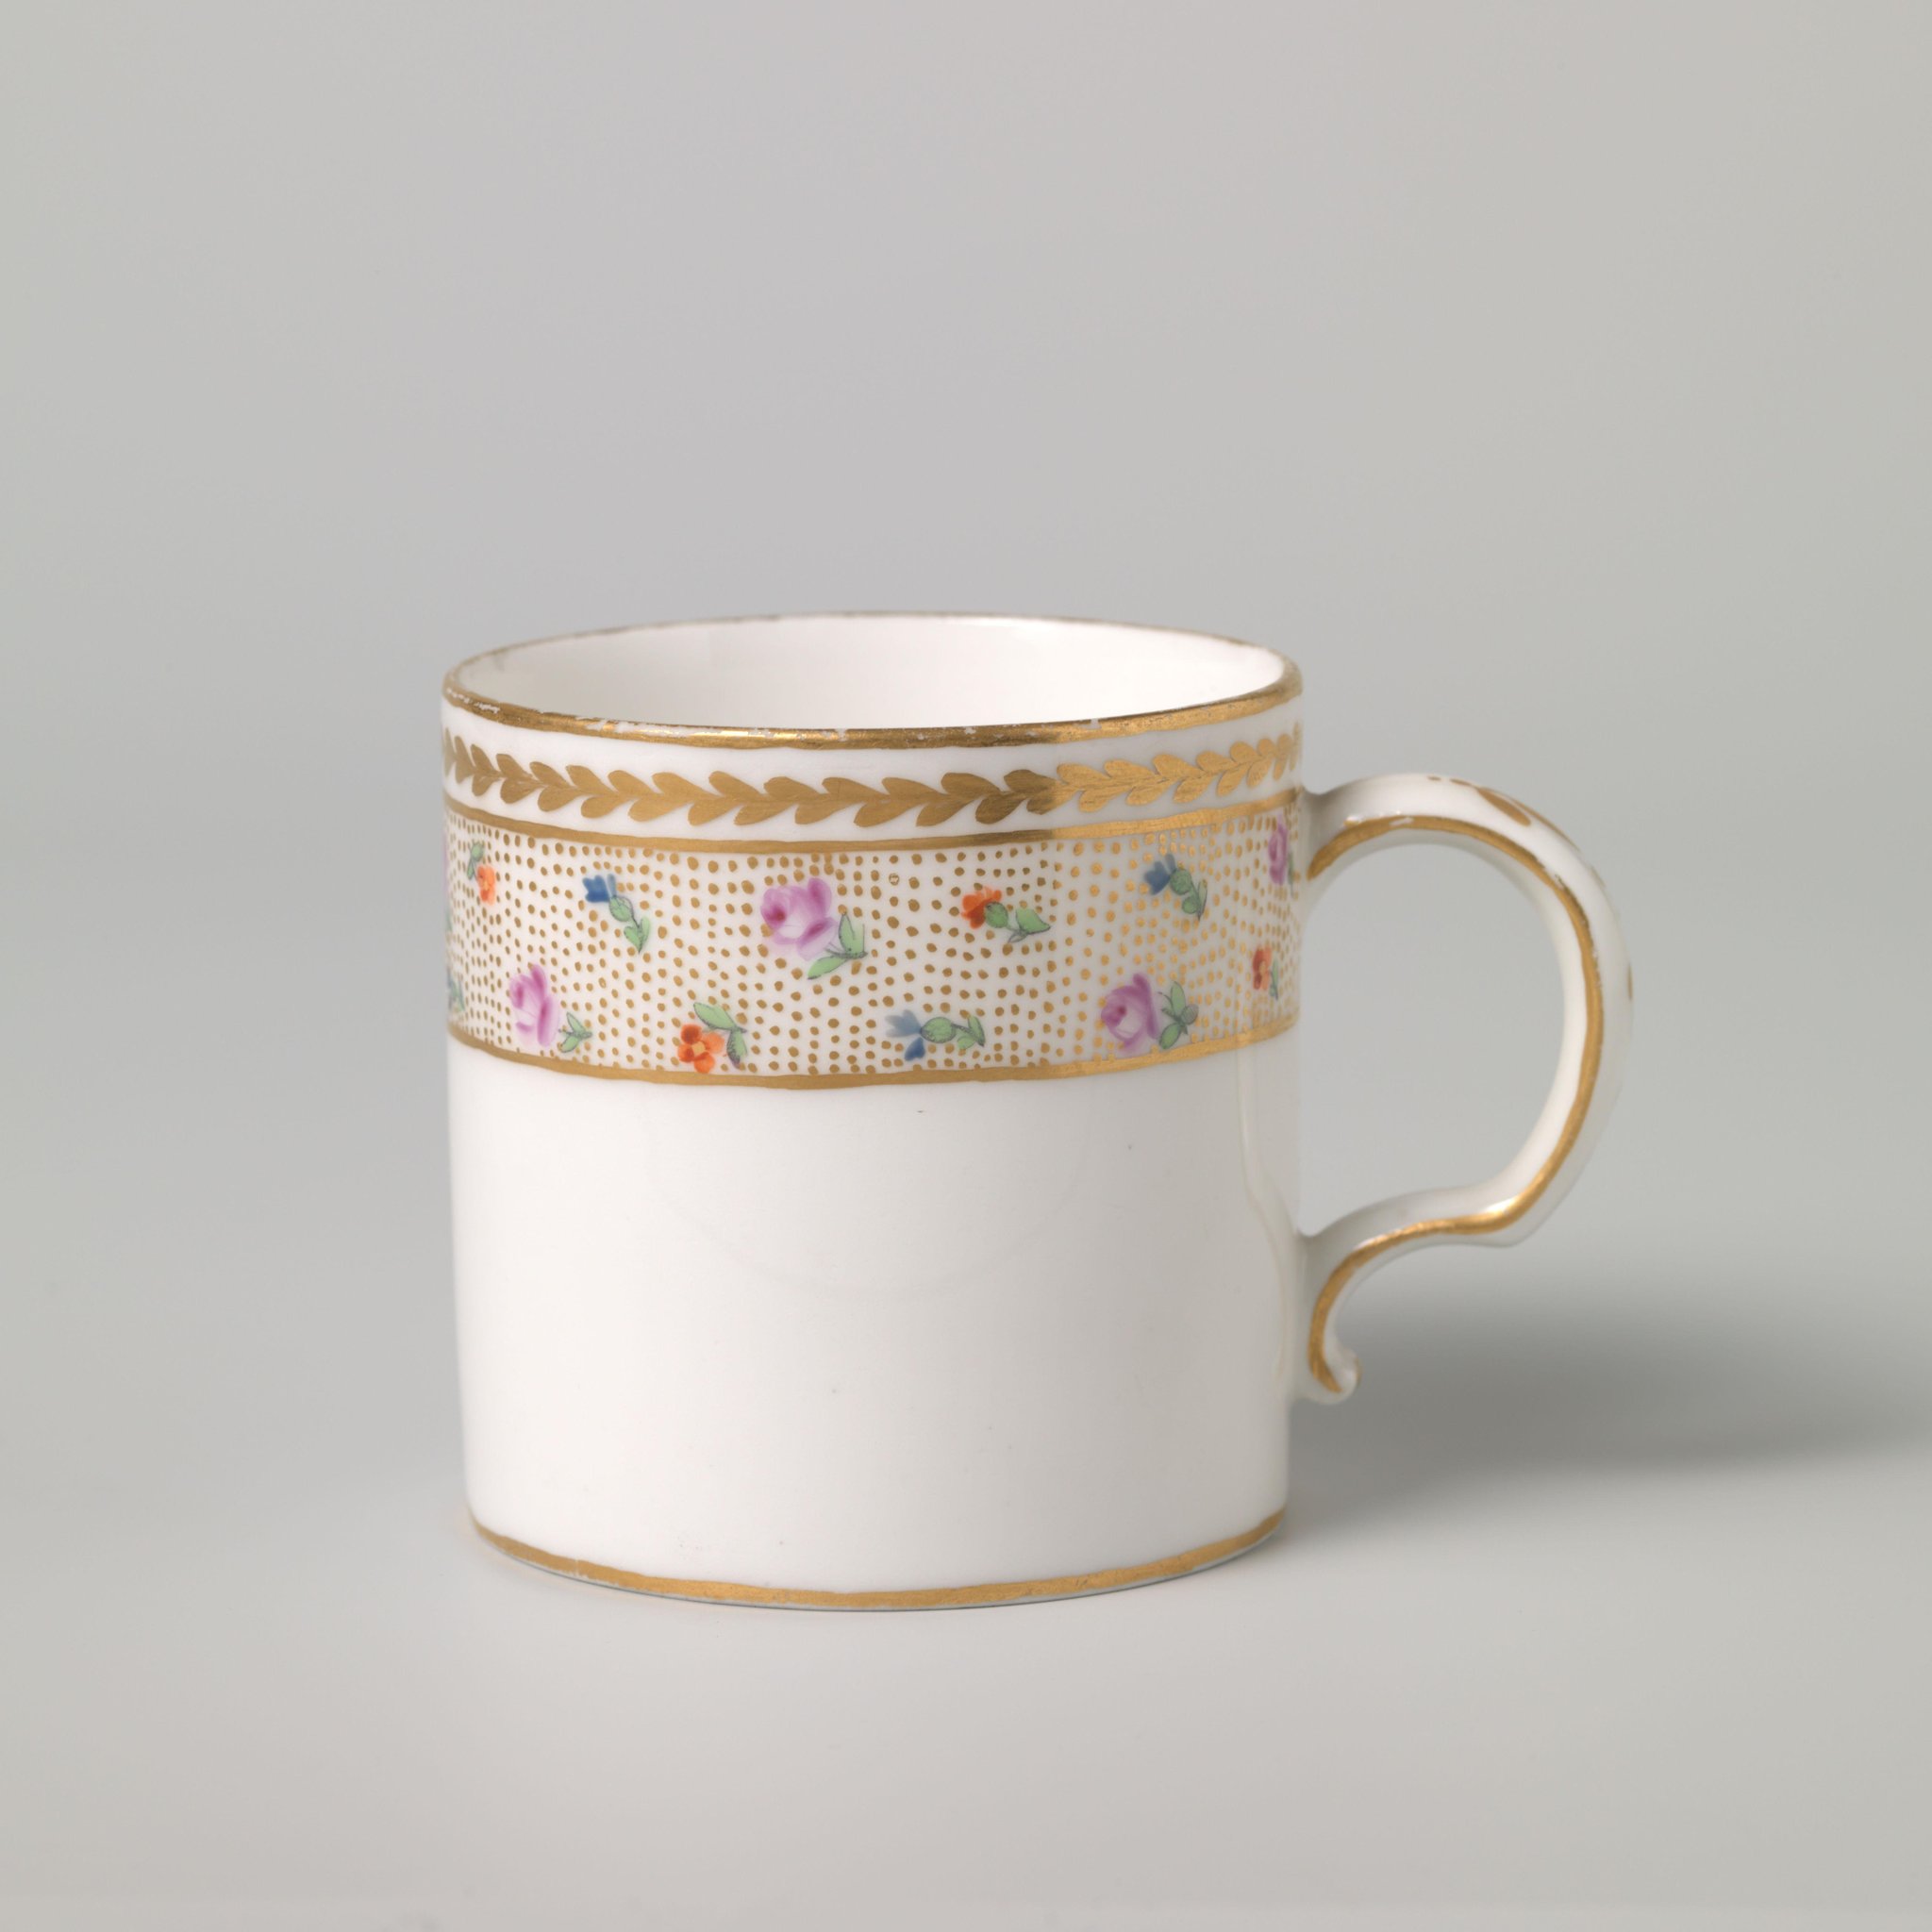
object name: cup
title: Cup with flower sprays and a foliate scroll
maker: Anonymous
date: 1790-1800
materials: glaze, gold, paint, porcelain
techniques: firing, forming, gilding, turning, vitrification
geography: france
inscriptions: mark: ‘D’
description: Kop van porselein met een cilindrische wand en C-vormig oor, beschilderd op het glazuur in blauw, rood, roze, groen en goud. Op de buitenrand een bladrank met daaronder een band gevuld met gouden stippen waarop bloemtakken. Gouden lijn op de voet en de rand. Bladmotieven en stippen op het oor. Gemerkt op de onderzijde met D.